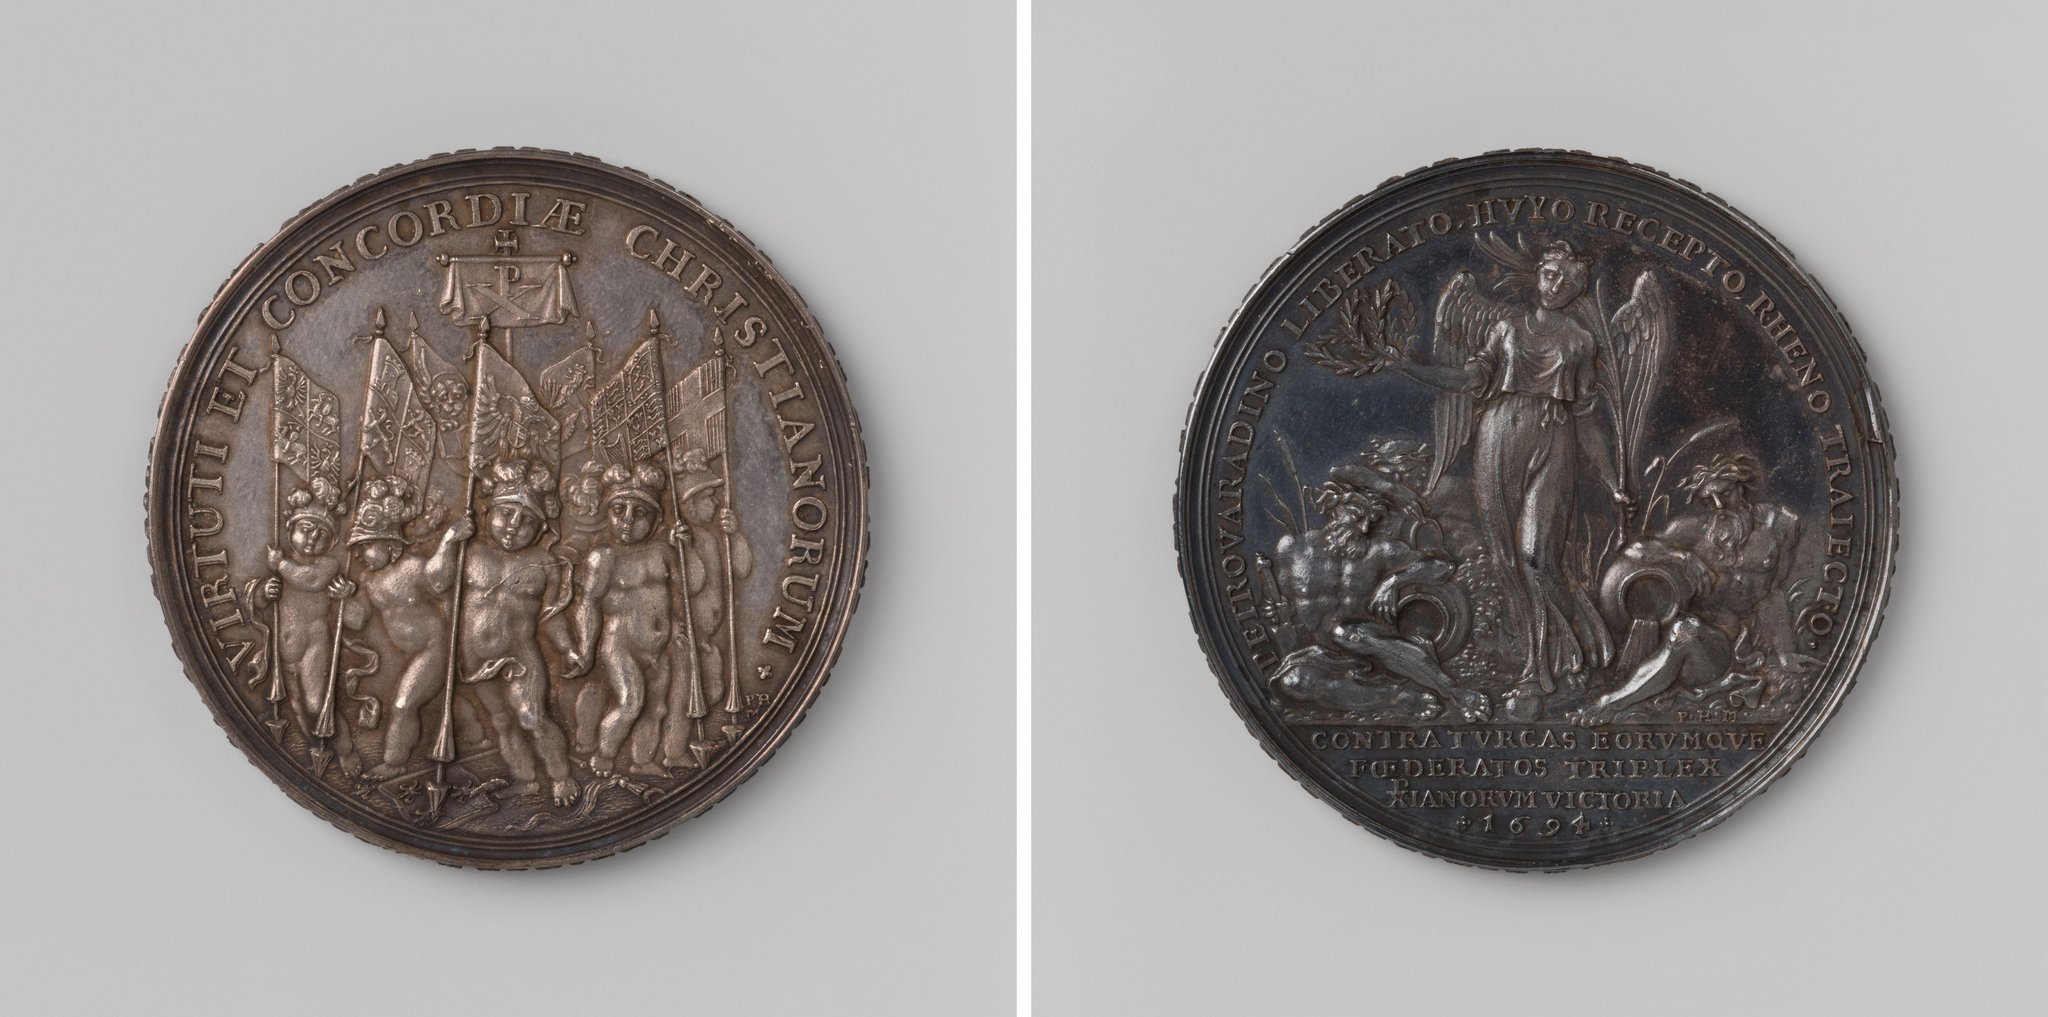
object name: history medal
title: Ontzet van Peterwaradin, innemen van Huy en overtrekken van de Rijn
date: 1694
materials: silver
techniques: striking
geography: nuremberg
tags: liège